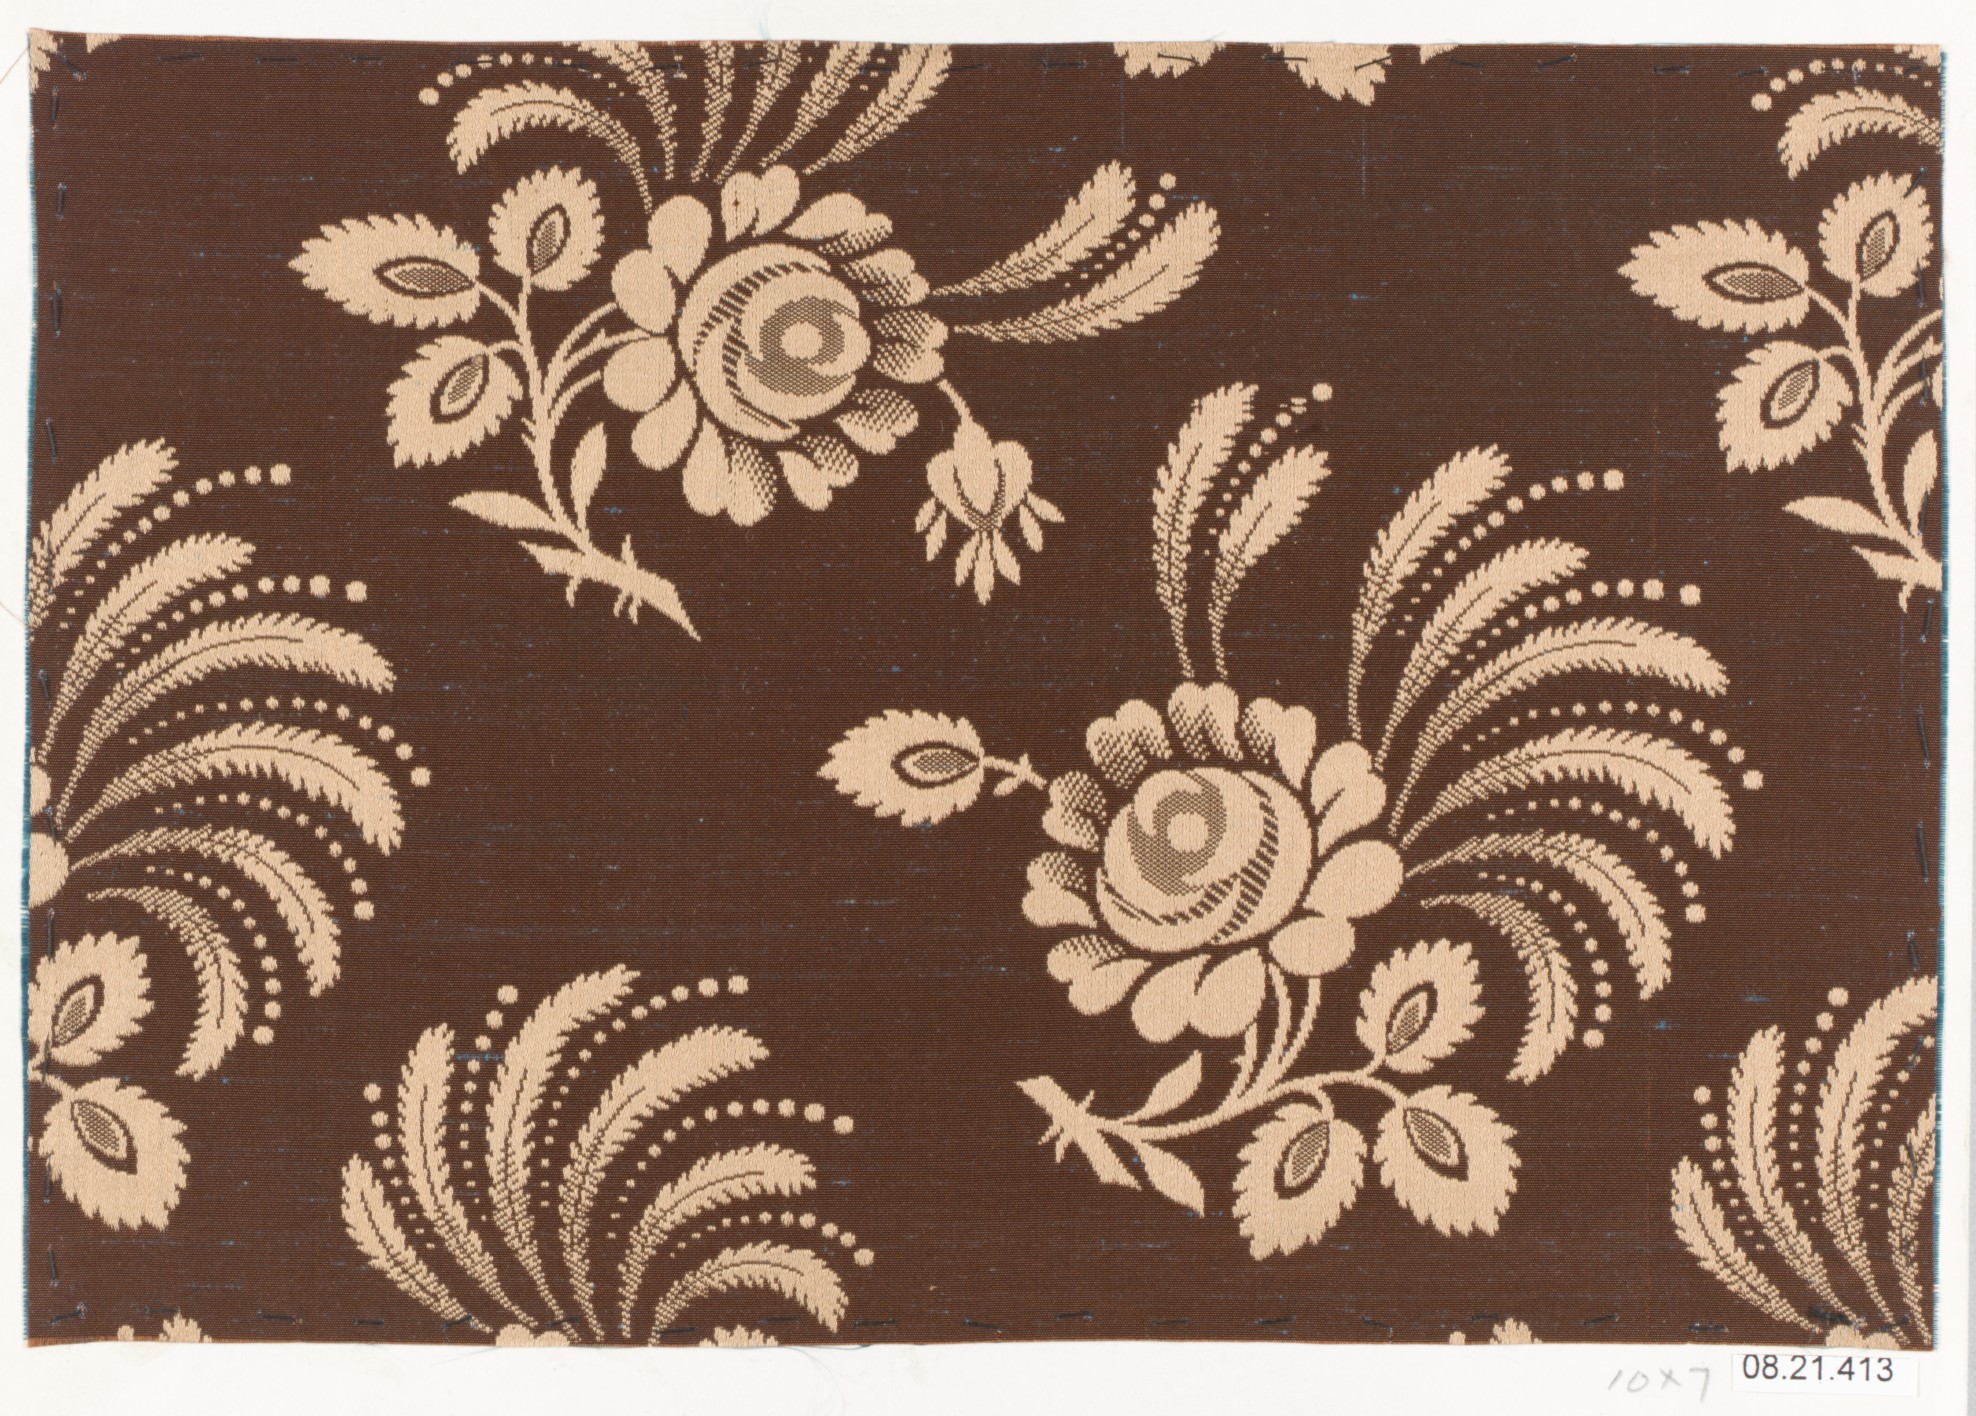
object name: textile sample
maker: Anonymous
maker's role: designer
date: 1900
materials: silk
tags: flowers,leaves